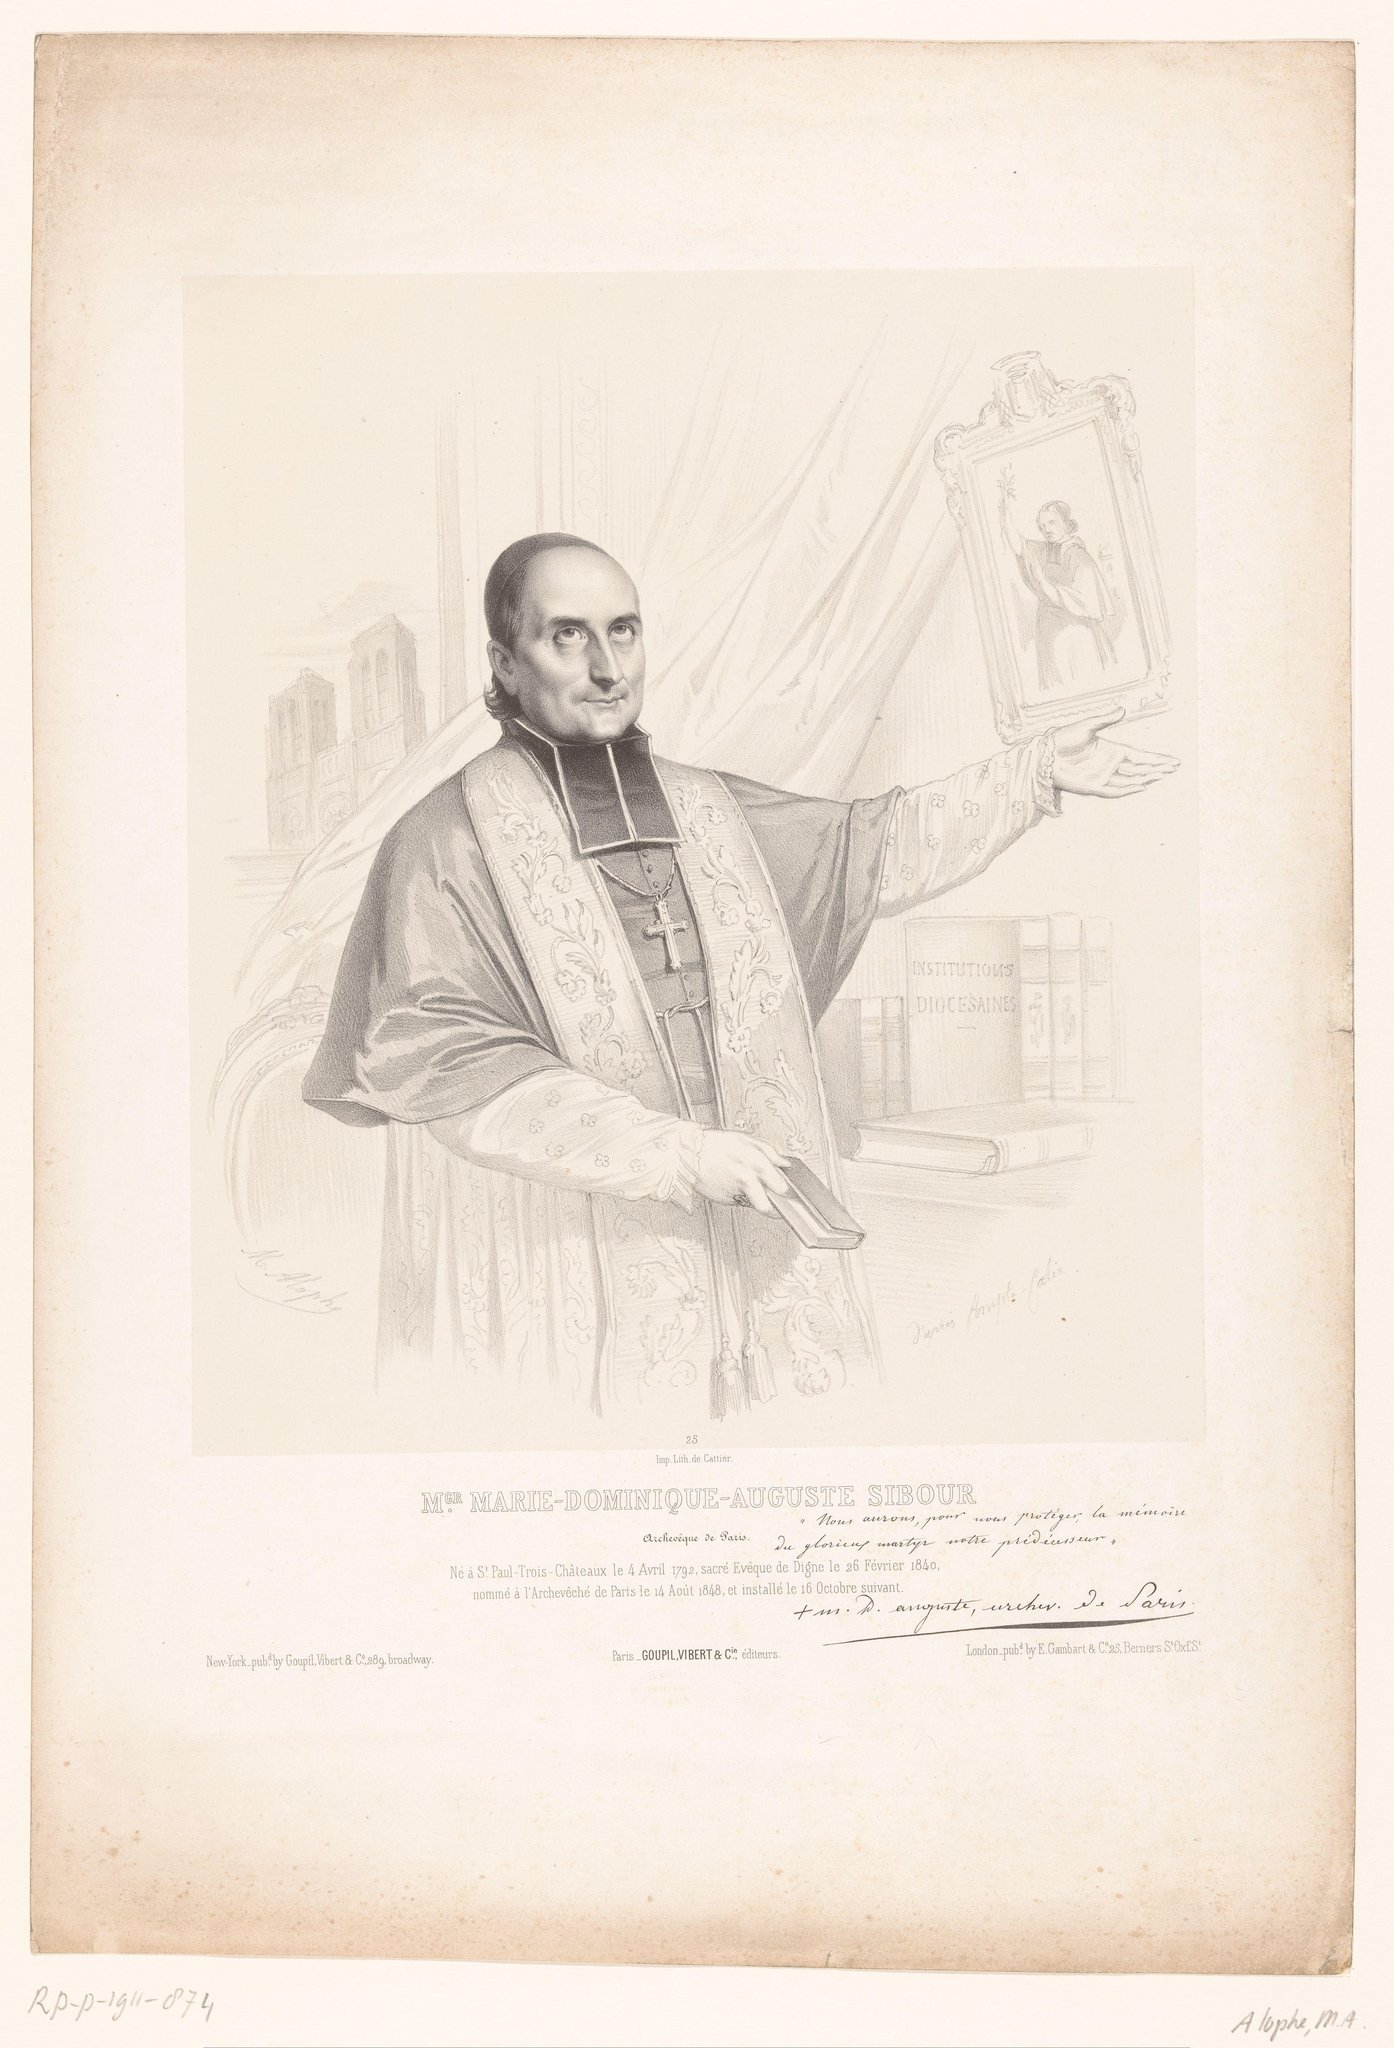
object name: print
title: Portret van Marie-Dominique-Auguste Sibour, aartsbisschop van Parijs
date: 1848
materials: paper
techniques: lithography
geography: new york city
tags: paris, historical persons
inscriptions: collector's mark: Lugt 2228, check stamp: Lugt 5004